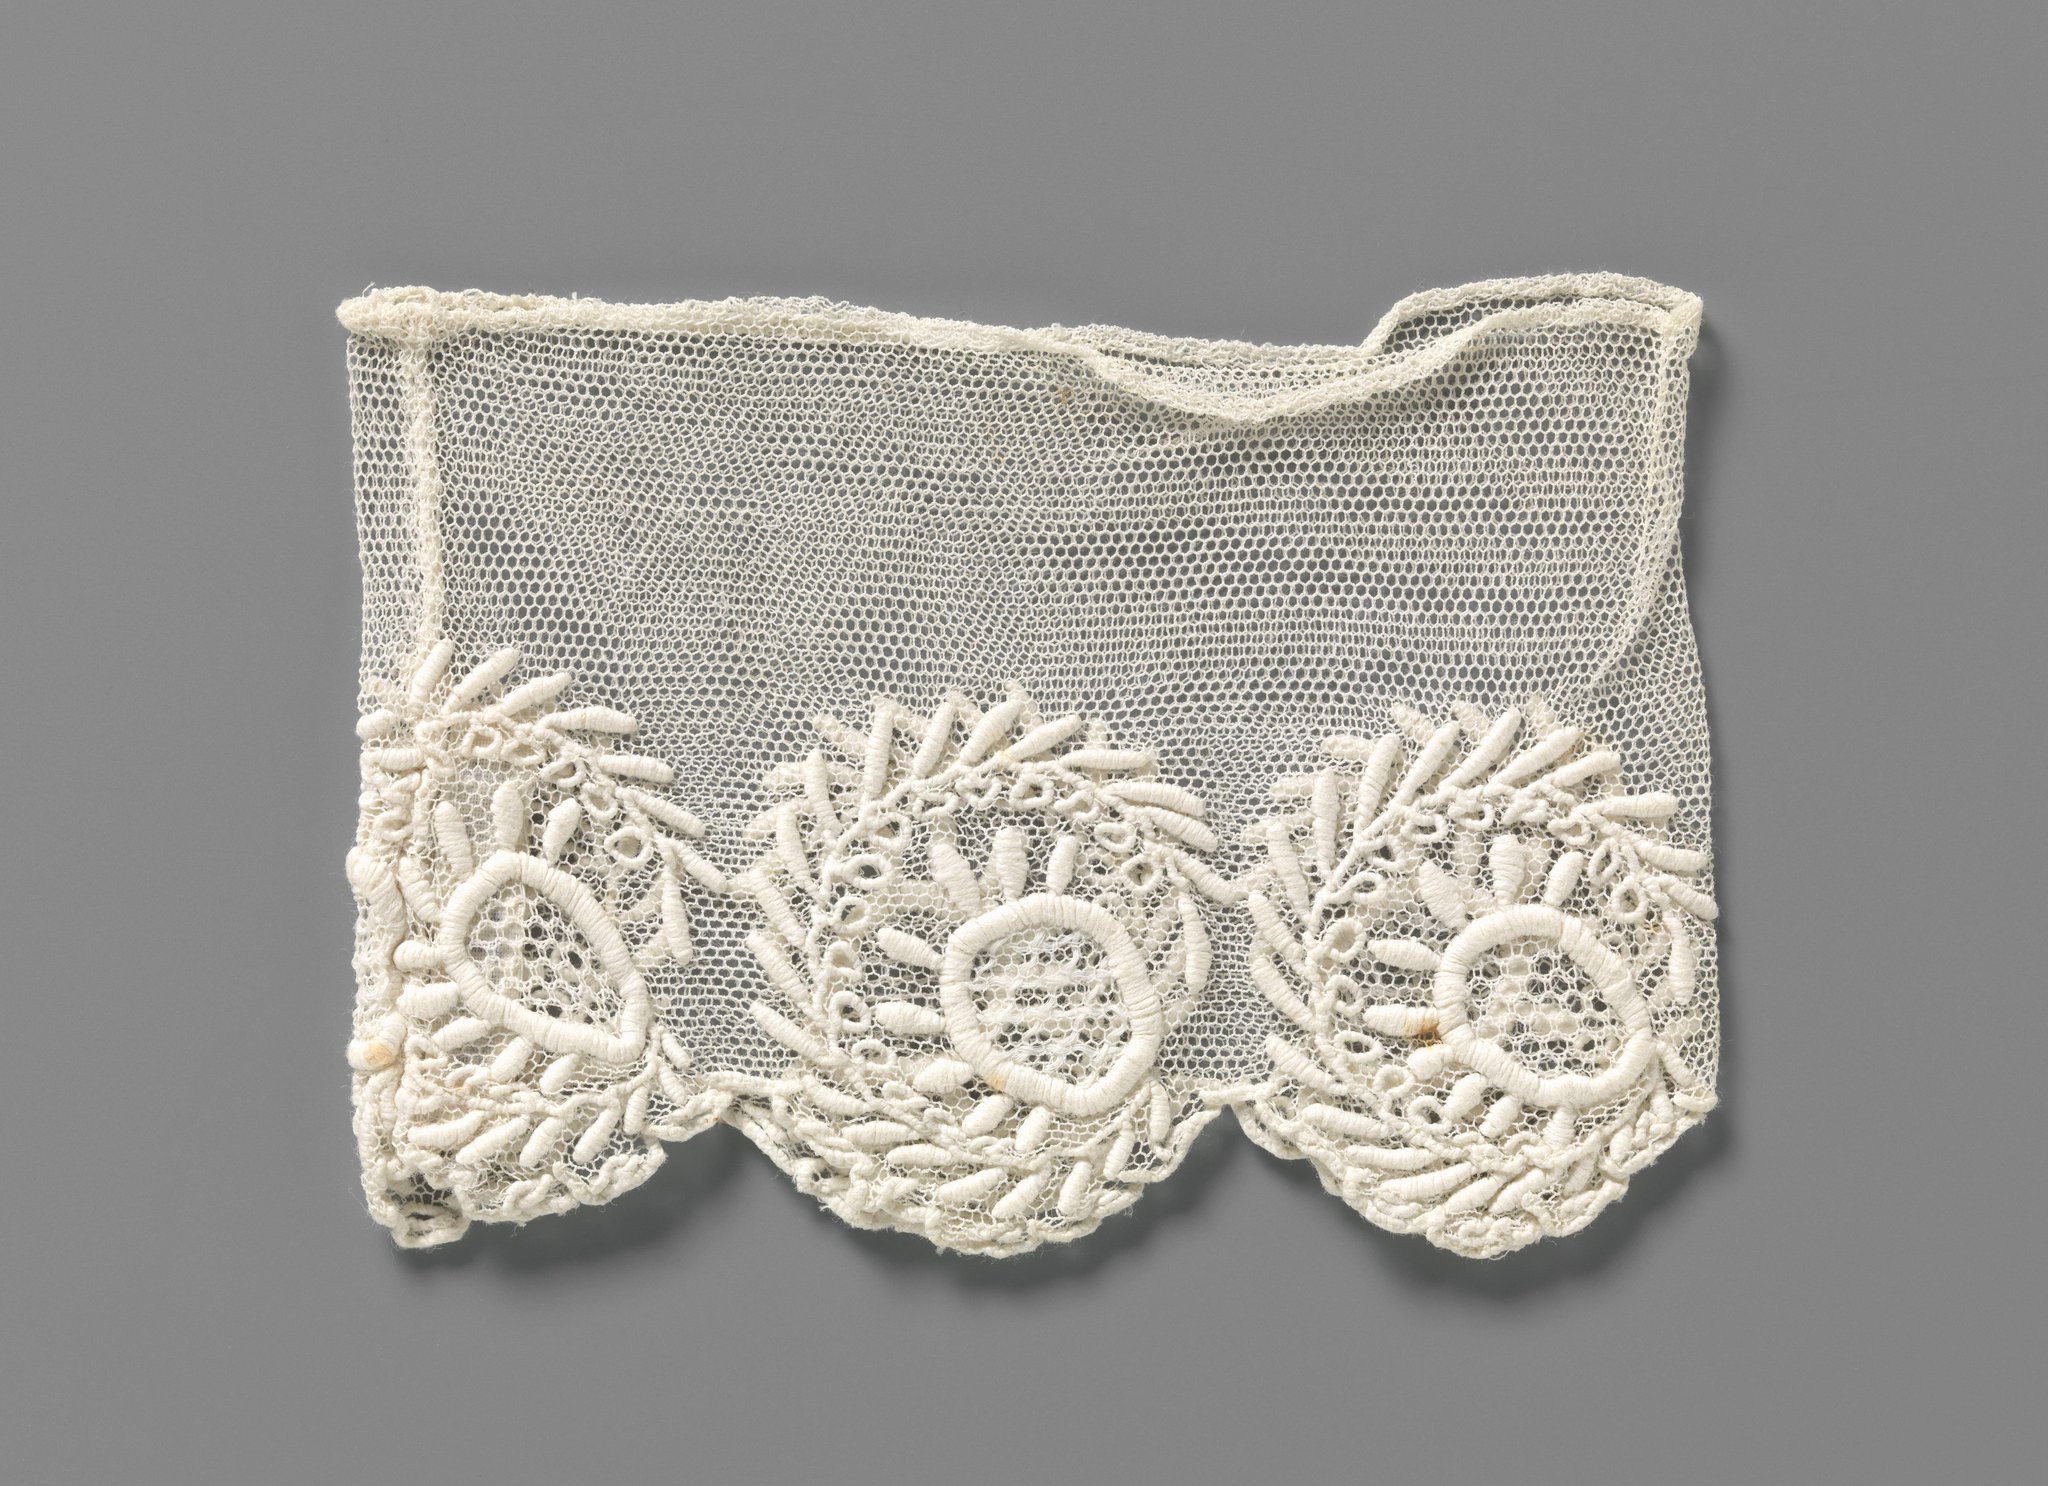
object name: womenswear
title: Manchet van kantborduurwerk met sikkelvormige gevederde tak die een cirkel omvat met stralen aan één zijde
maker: Anonymous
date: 1850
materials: cotton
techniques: lace embroidery, tulle embroidery, tulle ground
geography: netherlands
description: Manchet van naturelkleurig kantborduurwerk: borduurwerk op machinale tule. Rechthoekig model. Het zich herhalende patroon bestaat uit een sikkelvormige gevederde tak die een cirkel omvat met stralen aan één zijde. In de cirkels zijn verschillende machinale siergronden gezet waarachter al dan niet de tule is verwijderd. De schulpenrand langs de onderzijde vormt halfcirkelvormige schulpen rond de opeenvolgende sikkelvormig bladeren.